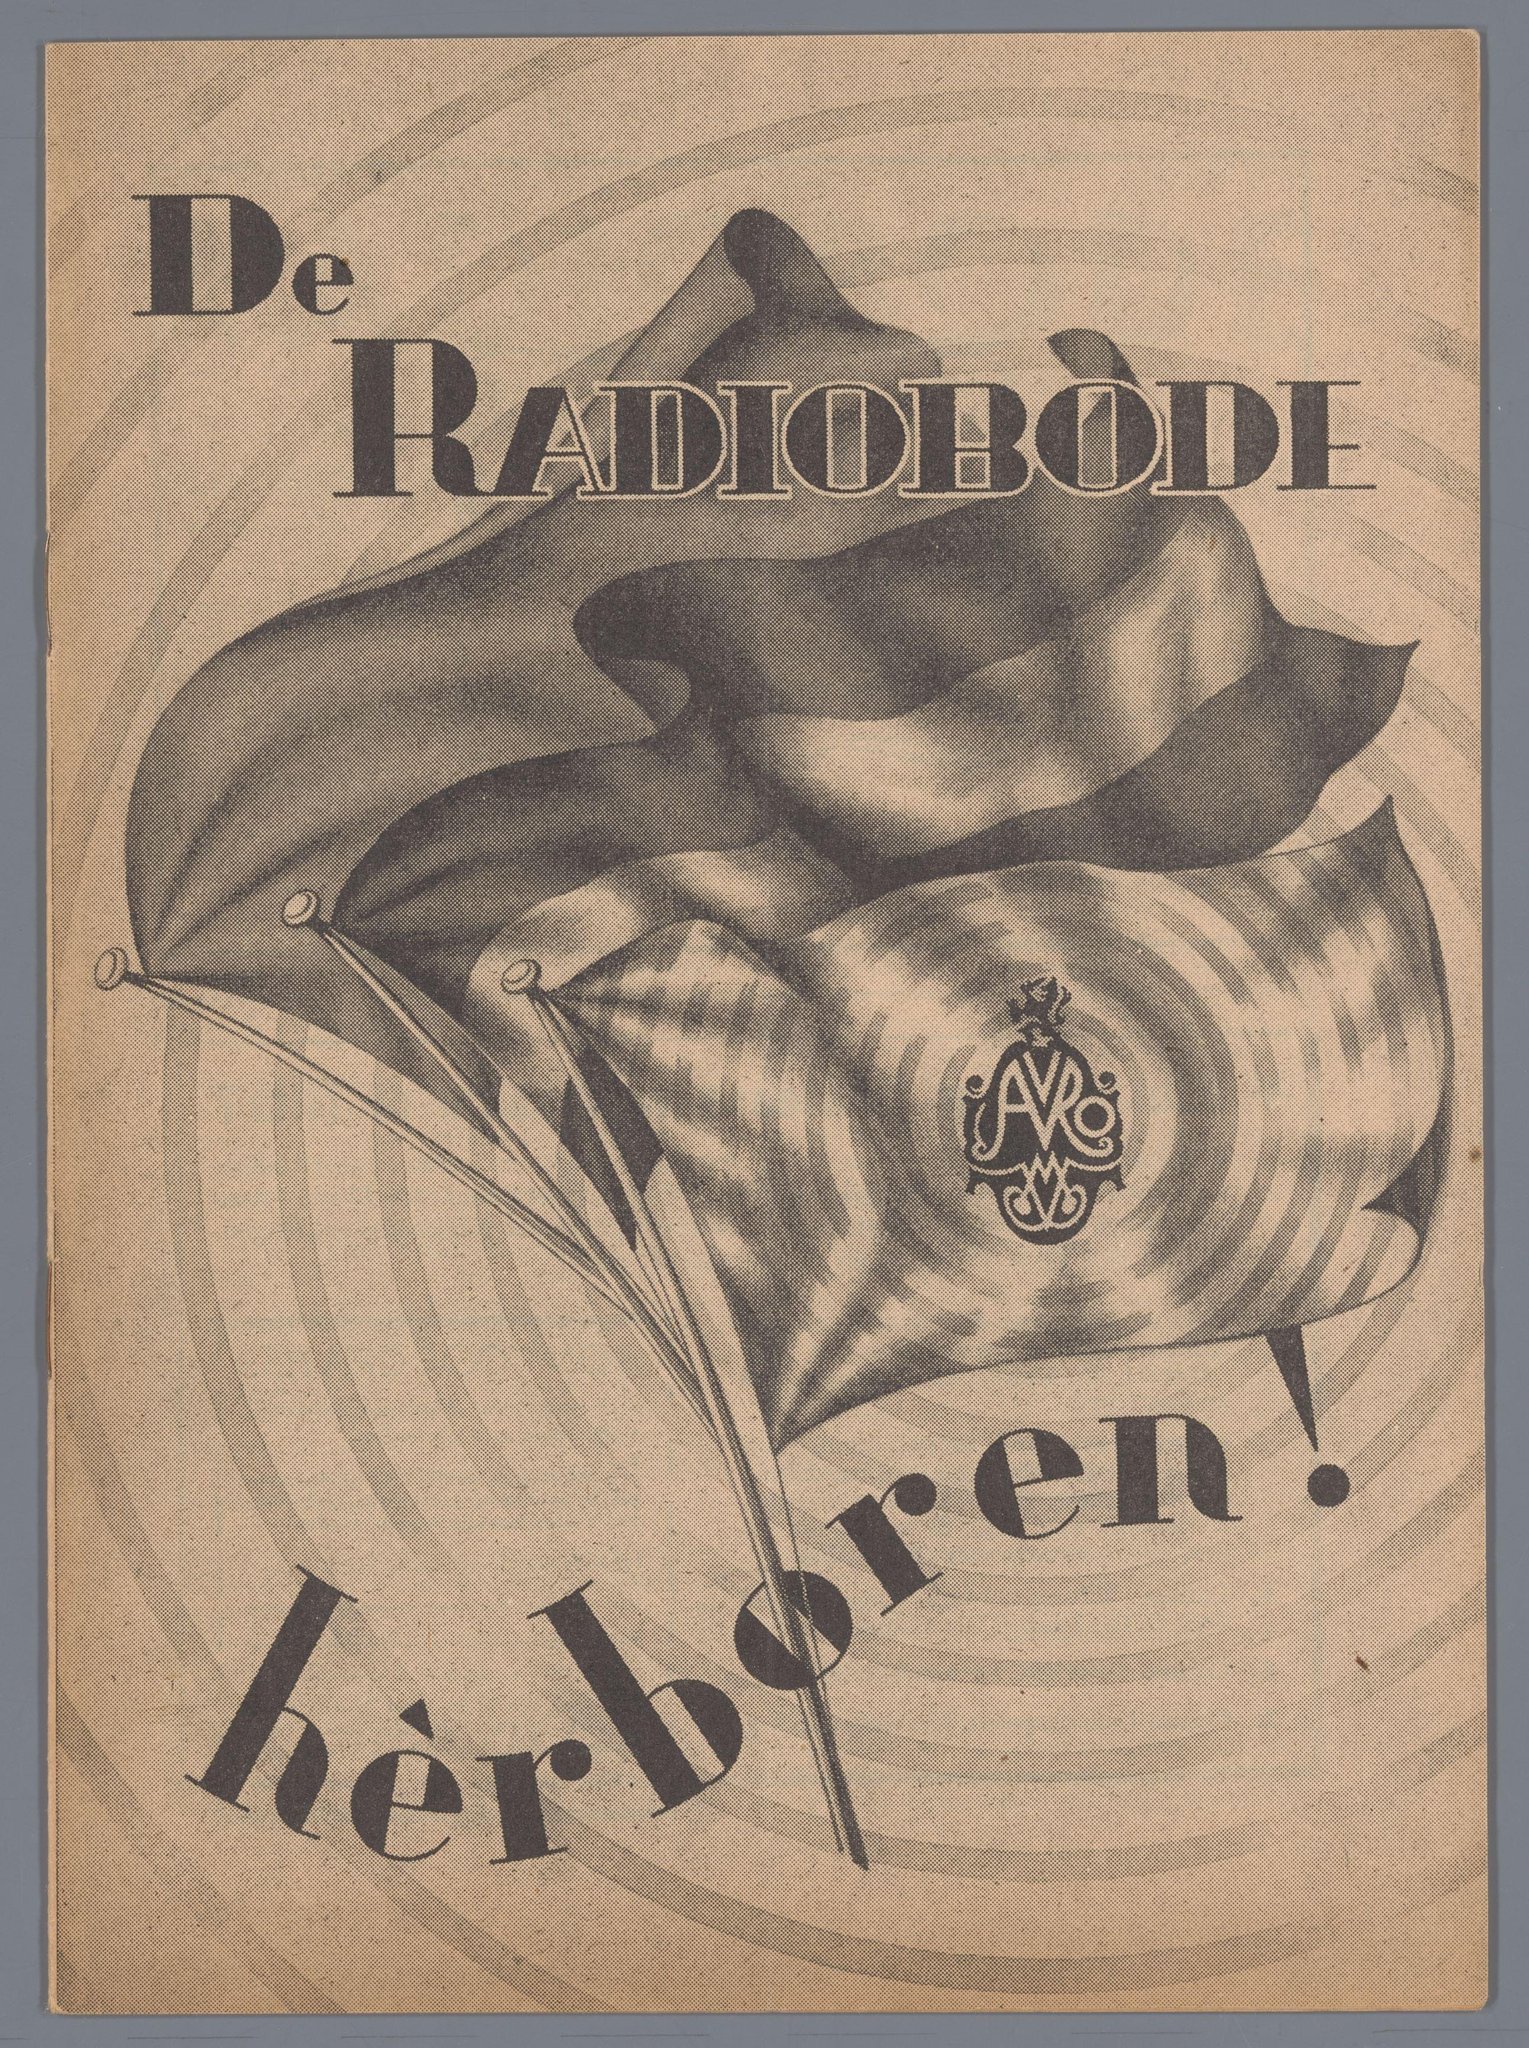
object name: magazine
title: De Radiobode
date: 1945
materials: paper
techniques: printing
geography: hilversum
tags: netherlands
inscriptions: date: ‘6 JULI 1945’, inscription: ‘De Radiobode hèrboren!’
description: In zwart-wit gedrukt blad, met 14 genummerde pagina's. Het blad bevat foto's en advertenties en korte artikelen van de Algemene vereniging "Radio Omroep". Het blad verschijnt wekelijks.